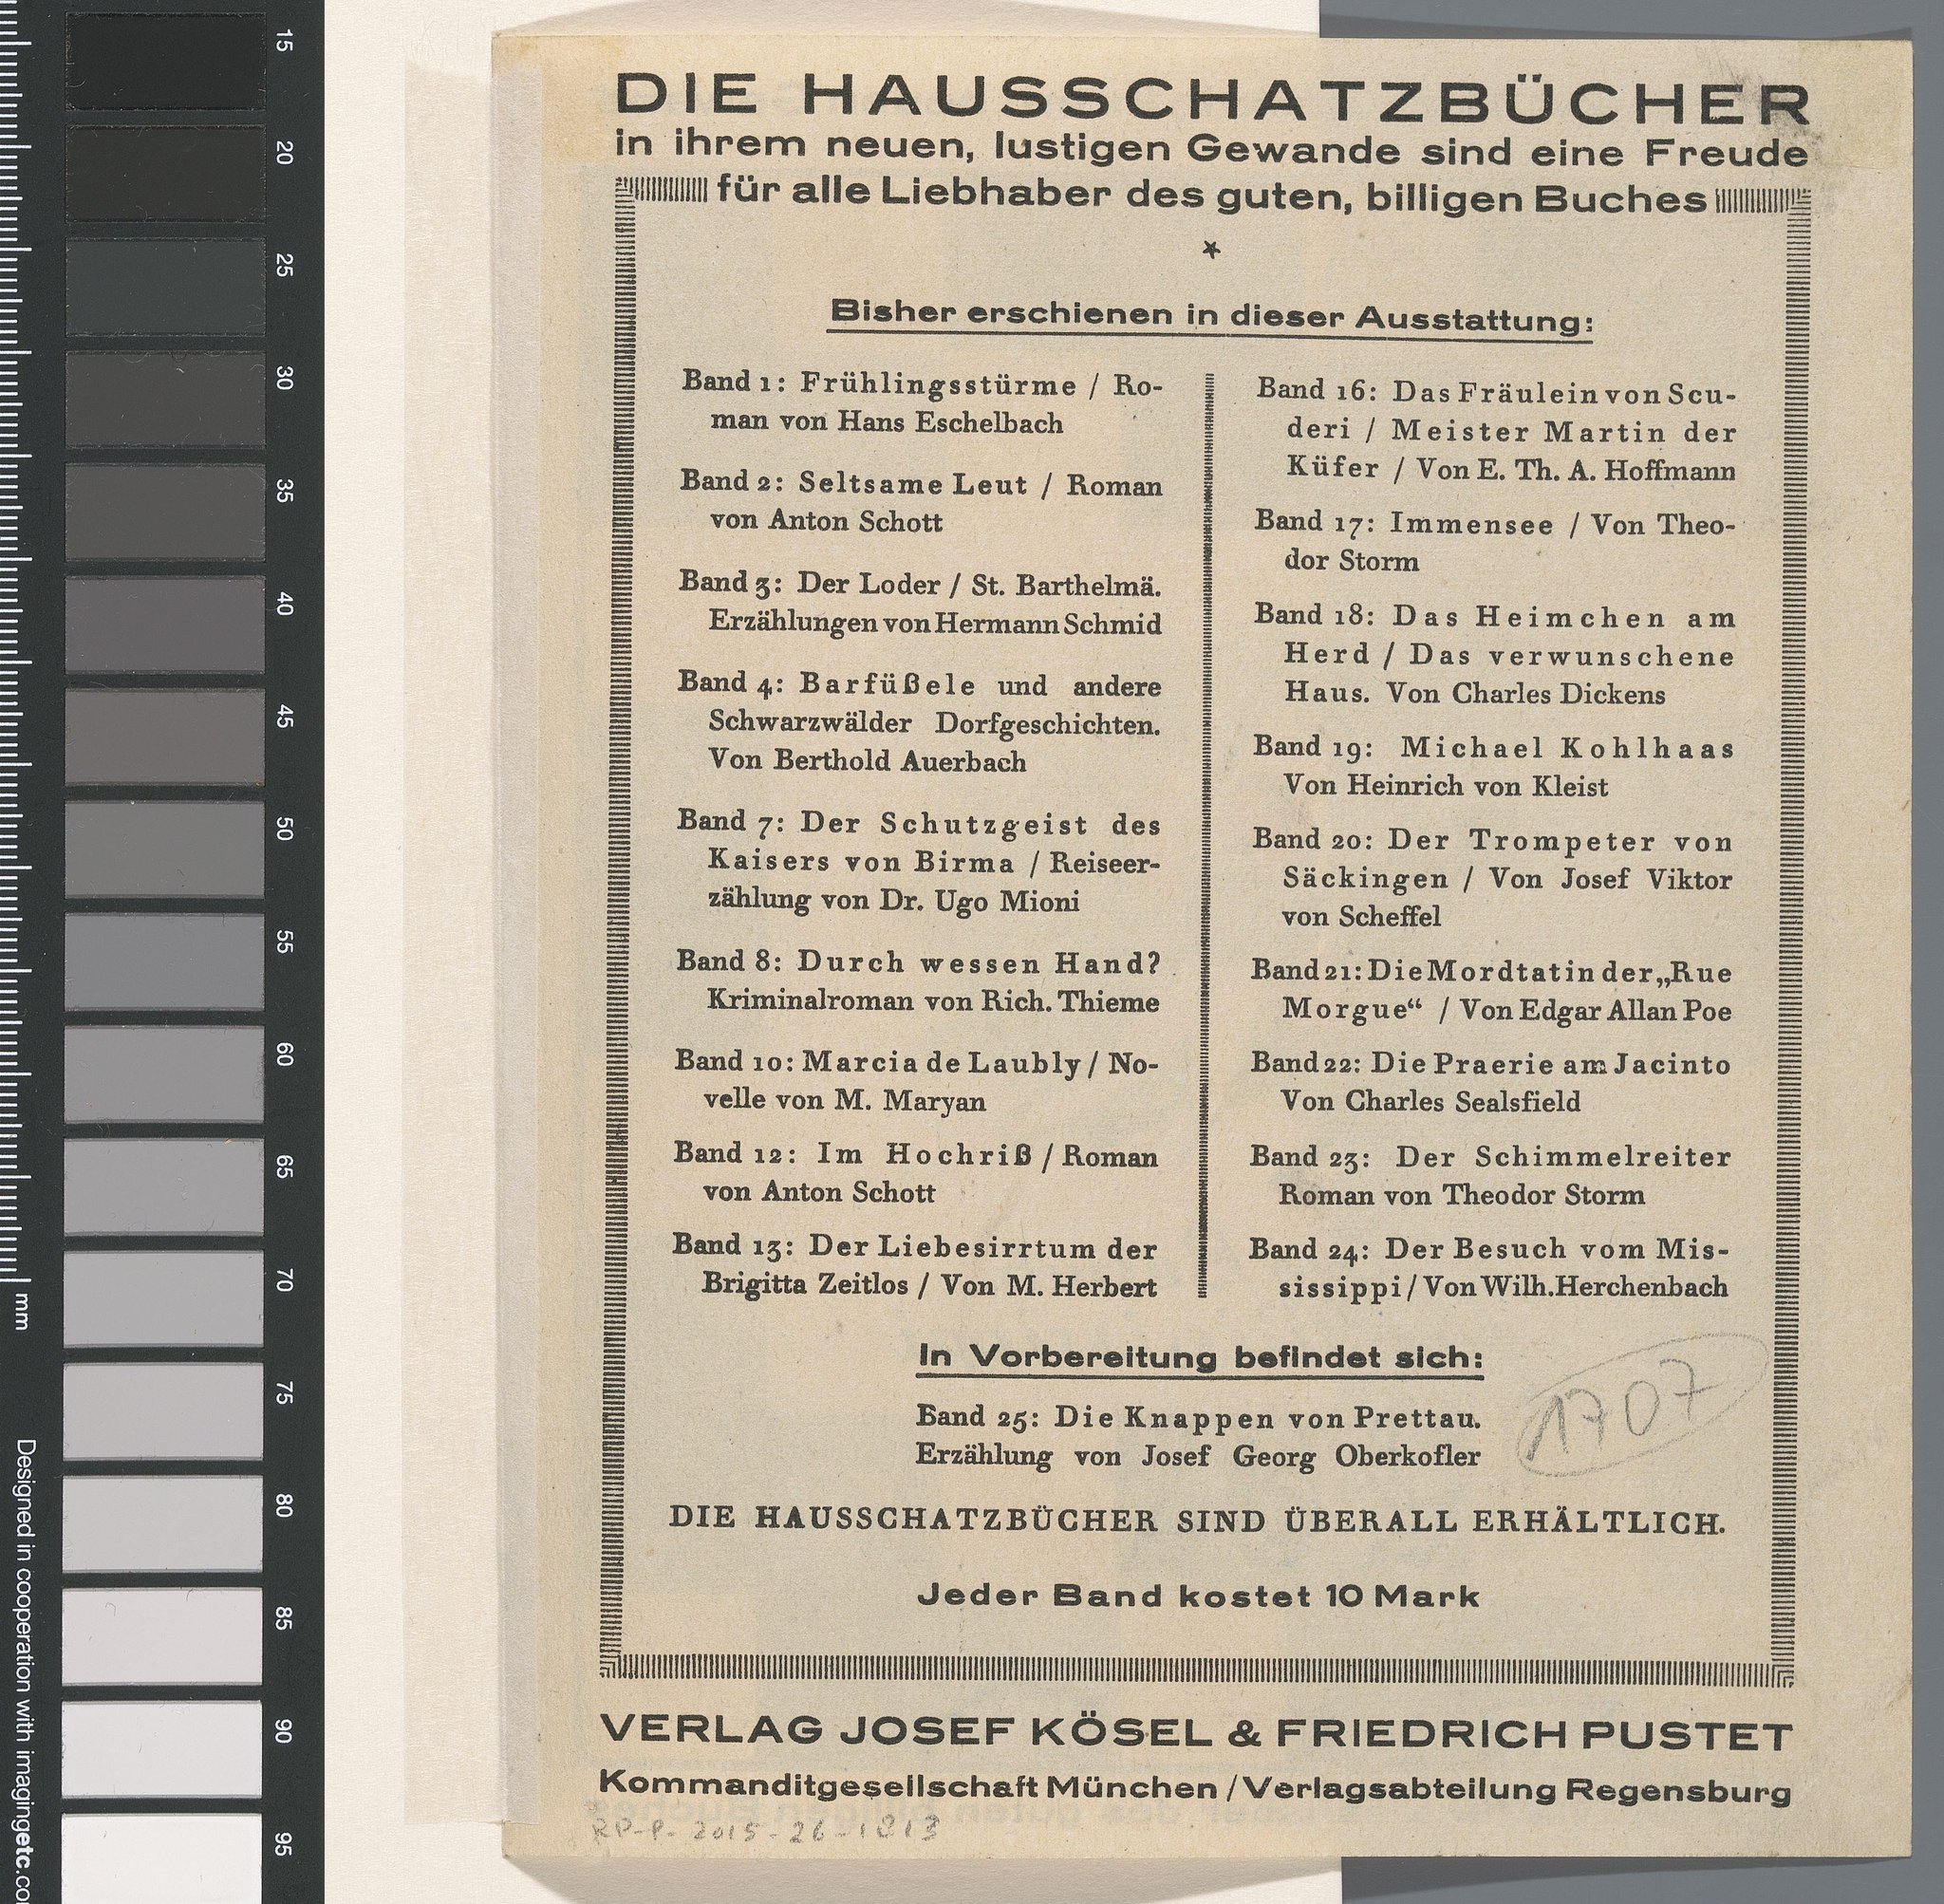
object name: print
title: Reclamebiljet voor Der Besuch vom Mississippi door Wilhelm Herchenbach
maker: Anonymous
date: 1922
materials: paper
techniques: lithograph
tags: seaman, americans with african roots, african-americans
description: Een zwarte man en een blanke matroos. In de achtergrond palmbomen en een zee met een zeilschip. Rondom een geometrisch patroon met de initialen van de uitgever en de naam van de serie waarin het werk verscheen.